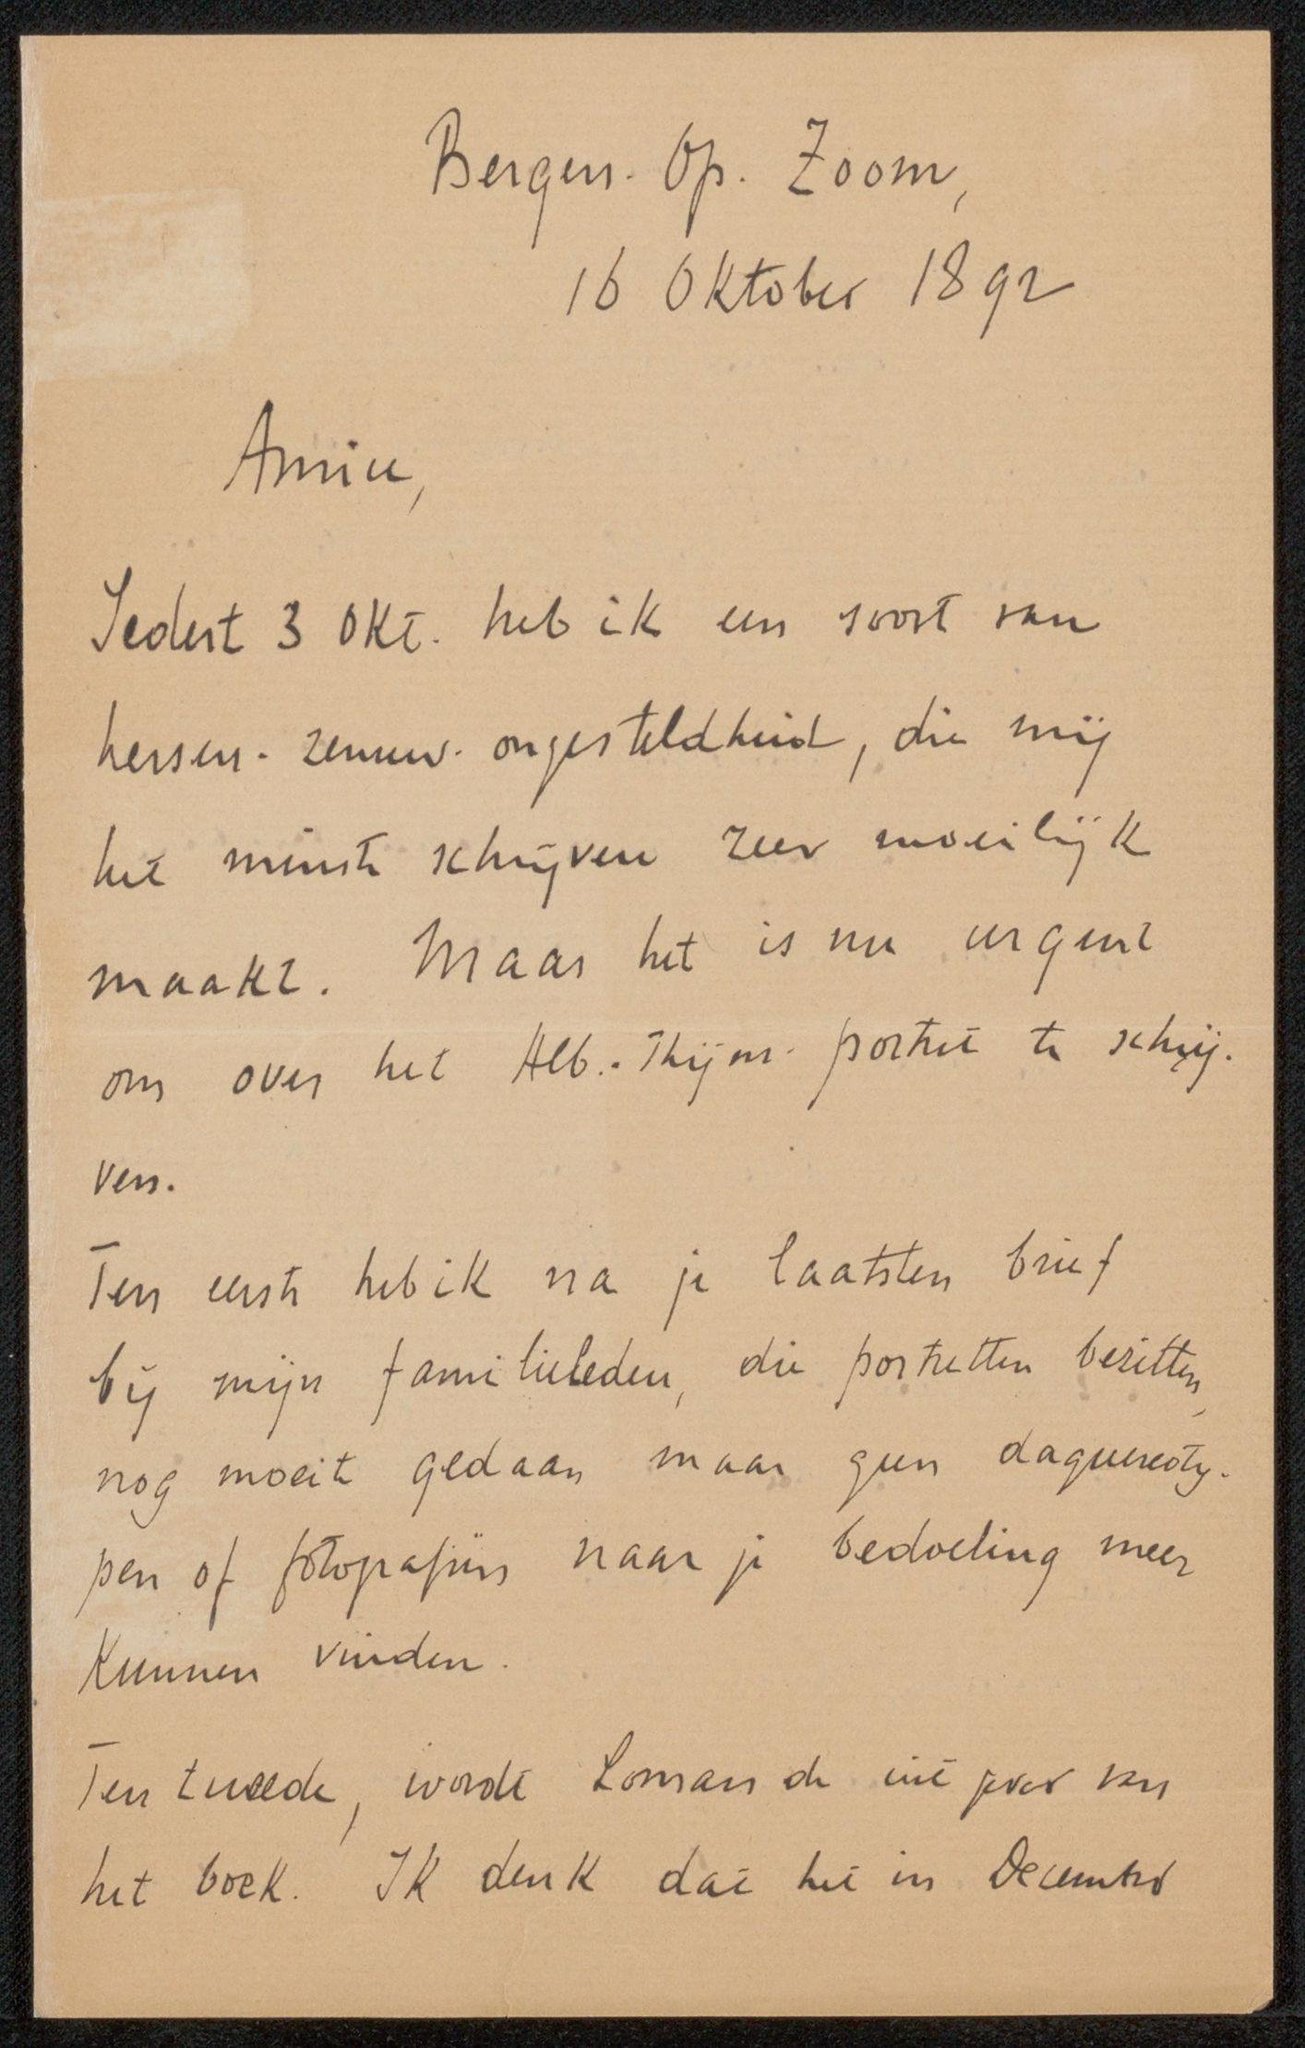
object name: letter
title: Brief aan Jan Veth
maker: karel johan lodewijk alberdingk thijm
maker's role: criticus, prozaschrijver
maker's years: 1864-1952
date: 1892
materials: ink, paper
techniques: pen, writing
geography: bergen op zoom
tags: the hague, publisher, jan christiaan jr. loman, dordrecht, amsterdam, painter, print maker, draughtsman, designer, jan veth, photography, cinematography, the graphic arts, anonymous historical person portrayed, diseases, printed matter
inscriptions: collector's mark: ‘RPK’